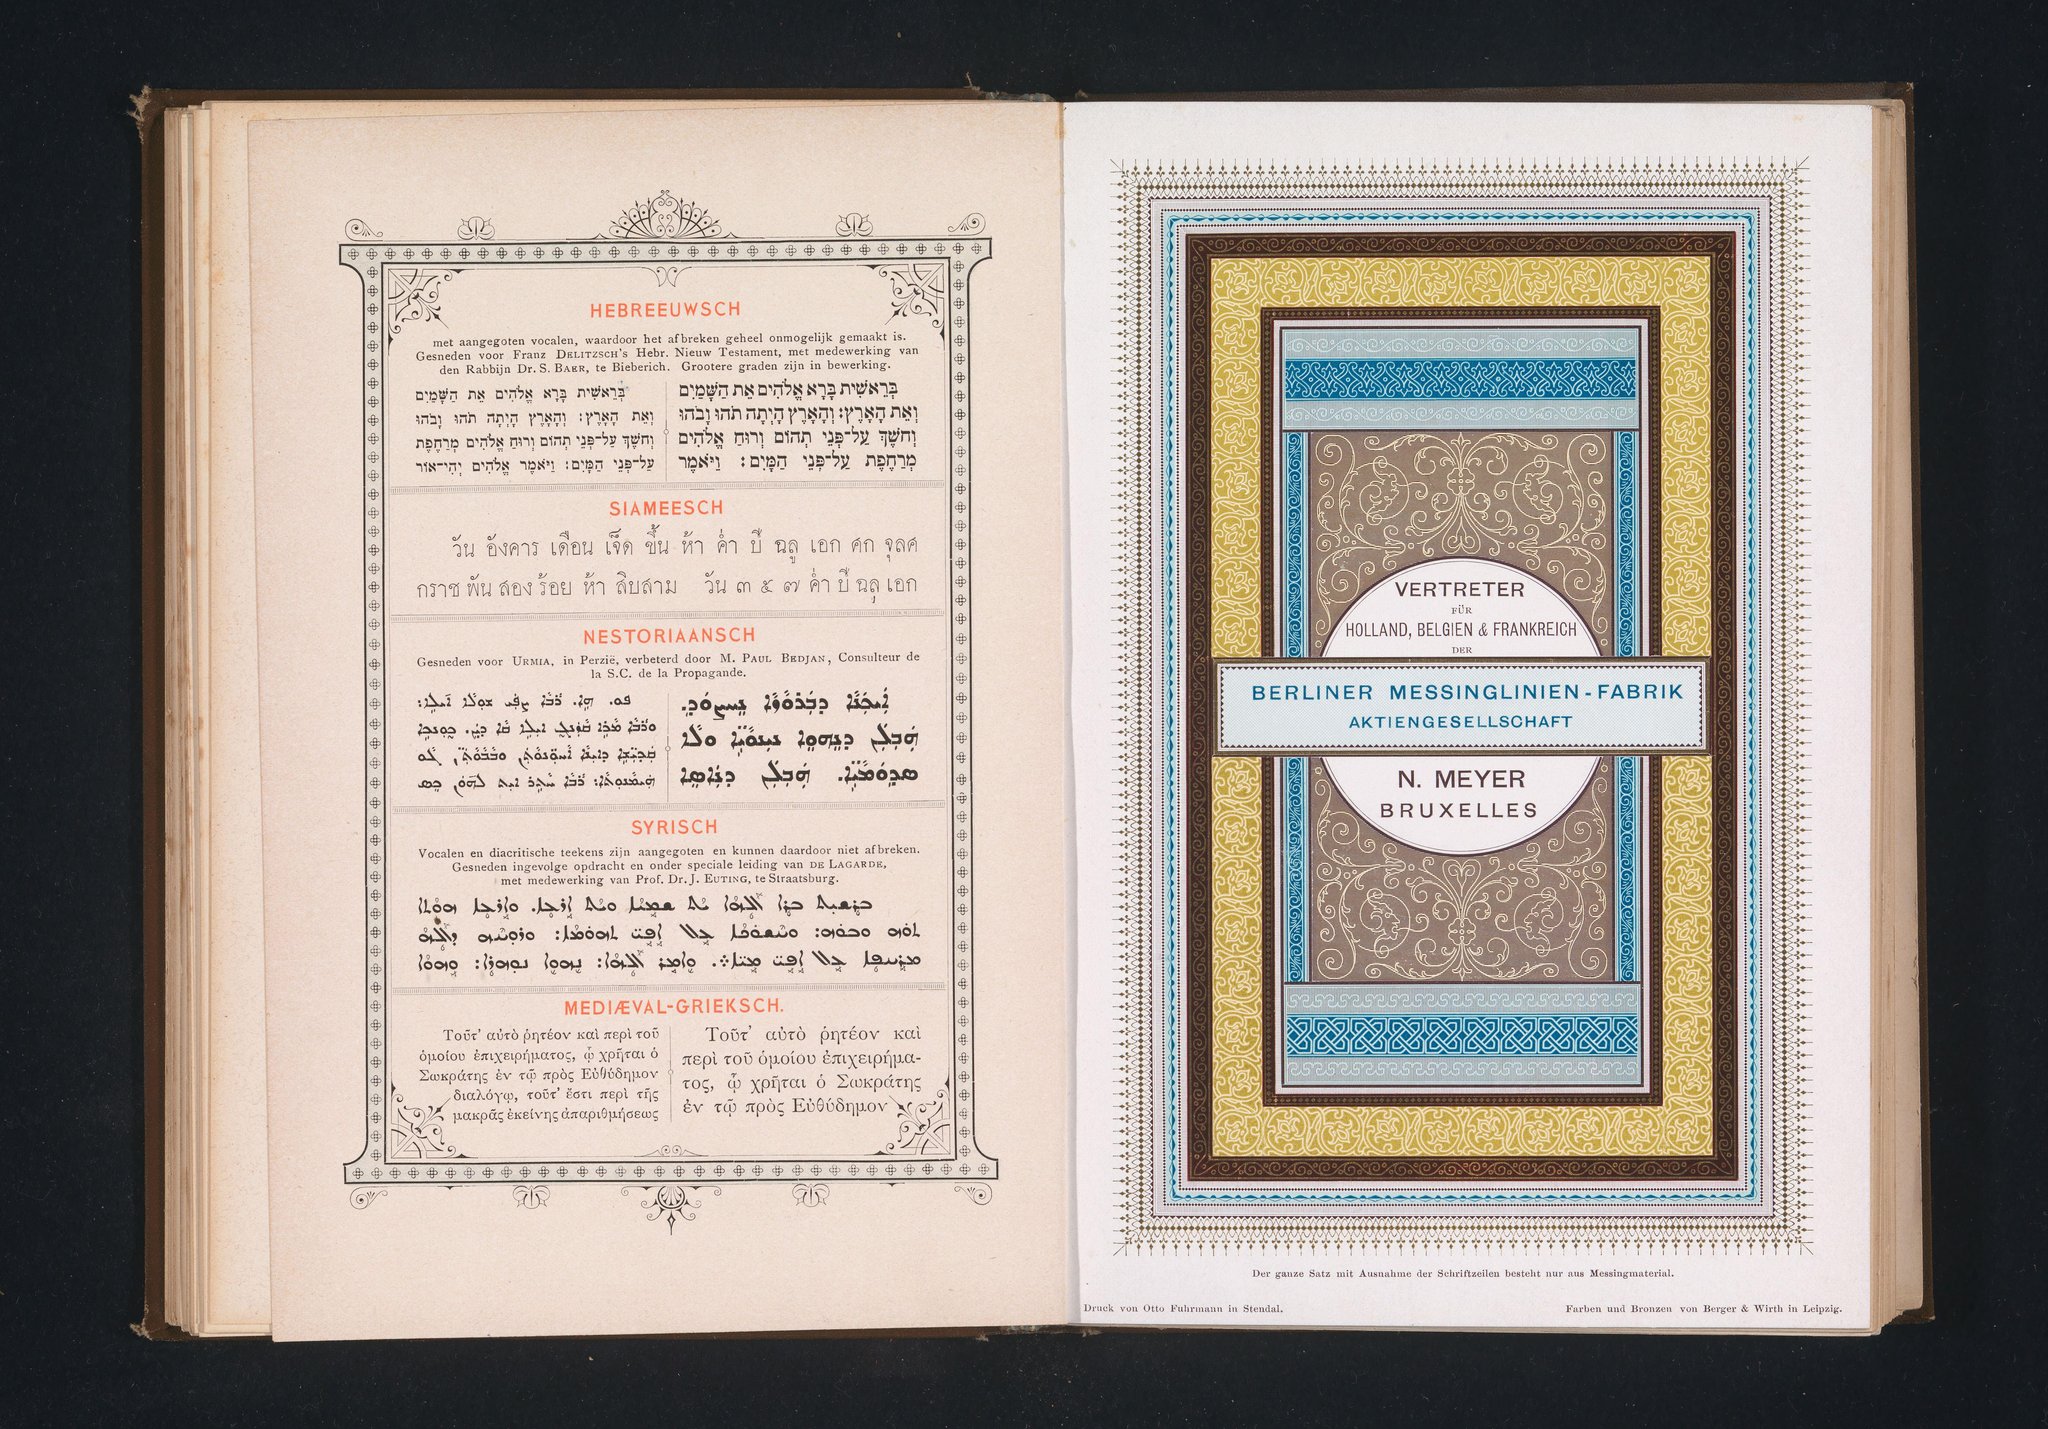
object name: photomechanical print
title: Vignet met reclameboodschap met gedecoreerde rand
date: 1887-1892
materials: paper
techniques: printing block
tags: fantasy ornament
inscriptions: inscription: ‘Der ganze Satz mit Ausnahme der Schriftzeilen besteht nur aus Messingmaterial.’, inscription: ‘Farben und Bronzen von Berger & Wirth in Leipzig.’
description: Prent op derde ongenummerde pagina na pagina 88.